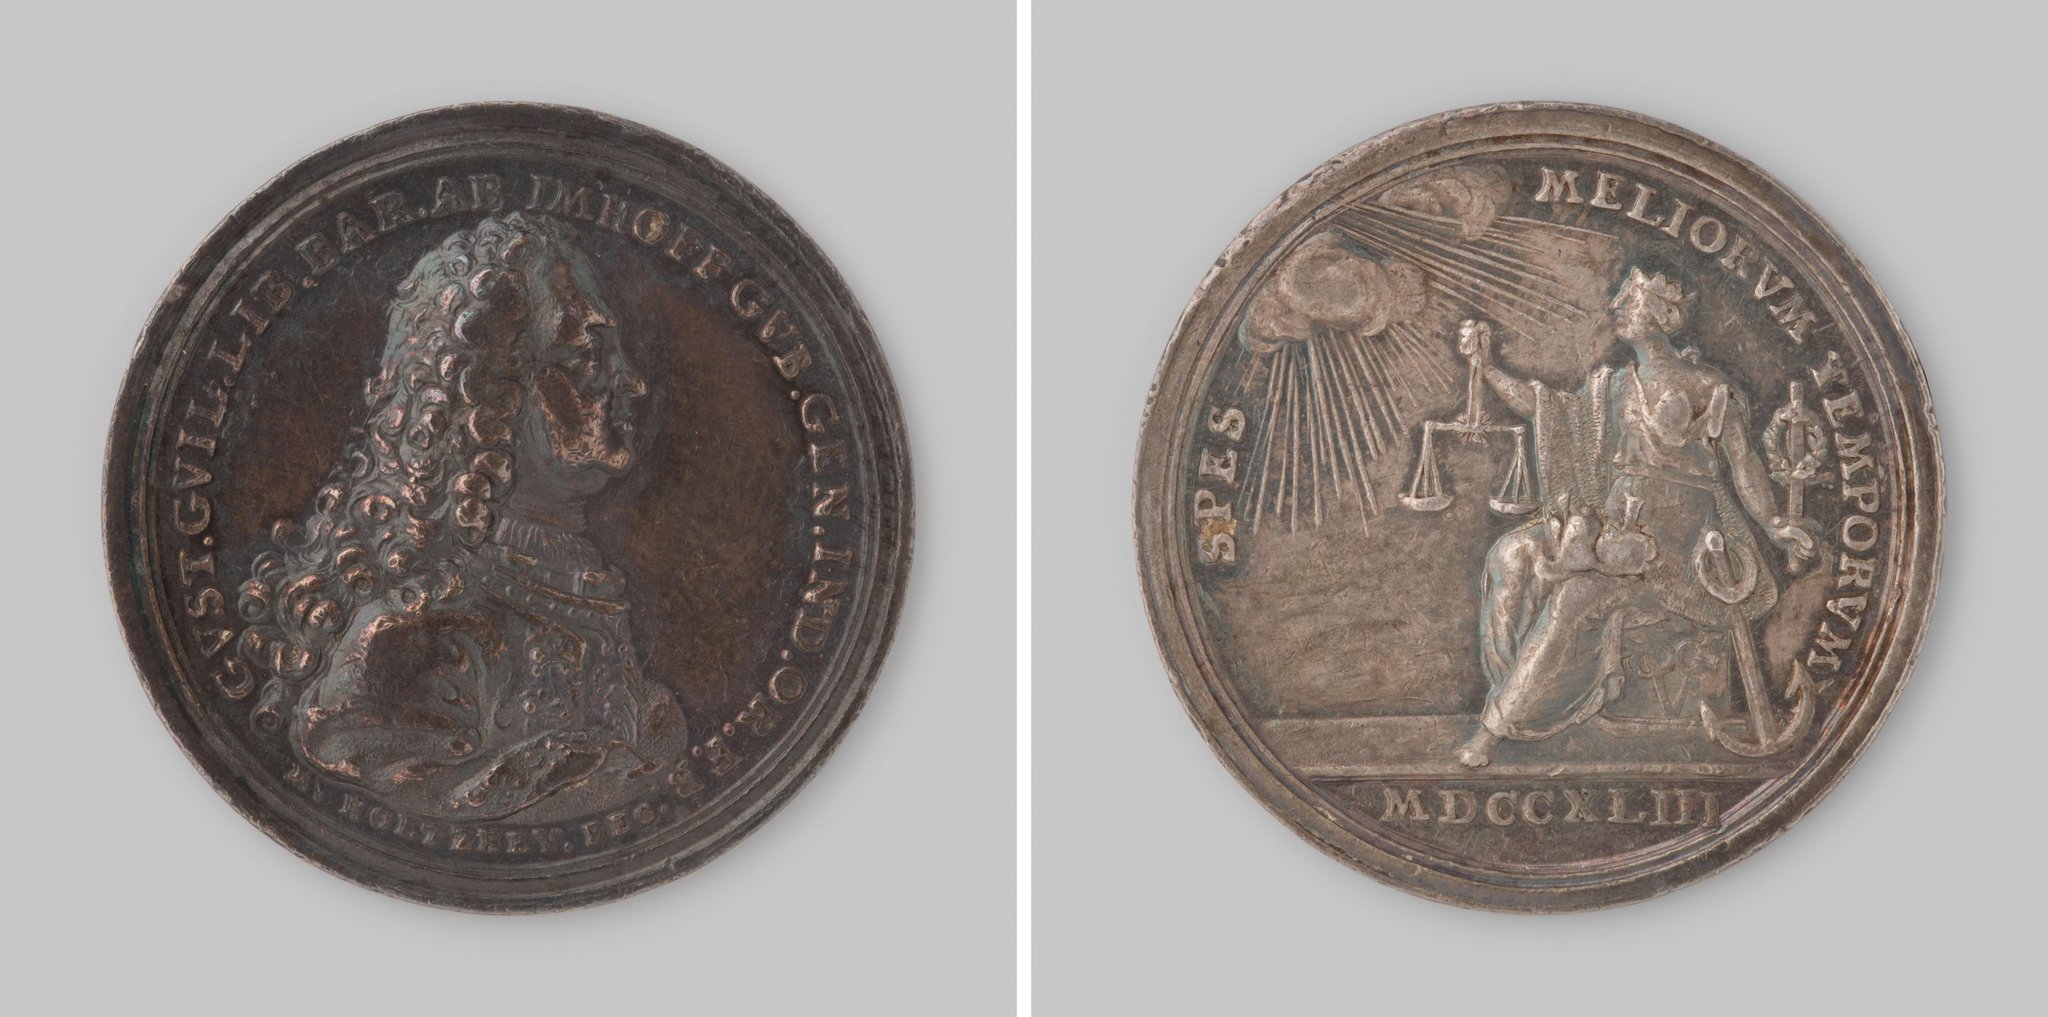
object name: history medal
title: Aankomst van baron Van Imhoff, gouverneur van Nederlands Oost Indië, aan Kaap de Goede Hoop 1743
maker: martinus holtzhey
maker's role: medailleur, muntmaker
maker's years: 1697-1764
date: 1743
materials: silver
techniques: striking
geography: amsterdam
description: Zilveren penning, op de voorzijde het borstbeeld van Van Imhoff naar rechts met omschrift, op de keerzijde de VOC als getroonde vrouw met weegschaal en zwaard met krans, een stralende hemel tegemoetziend, een anker tegen haar troon, met omschrift en jaartal MDCCXLIII in afsnede.